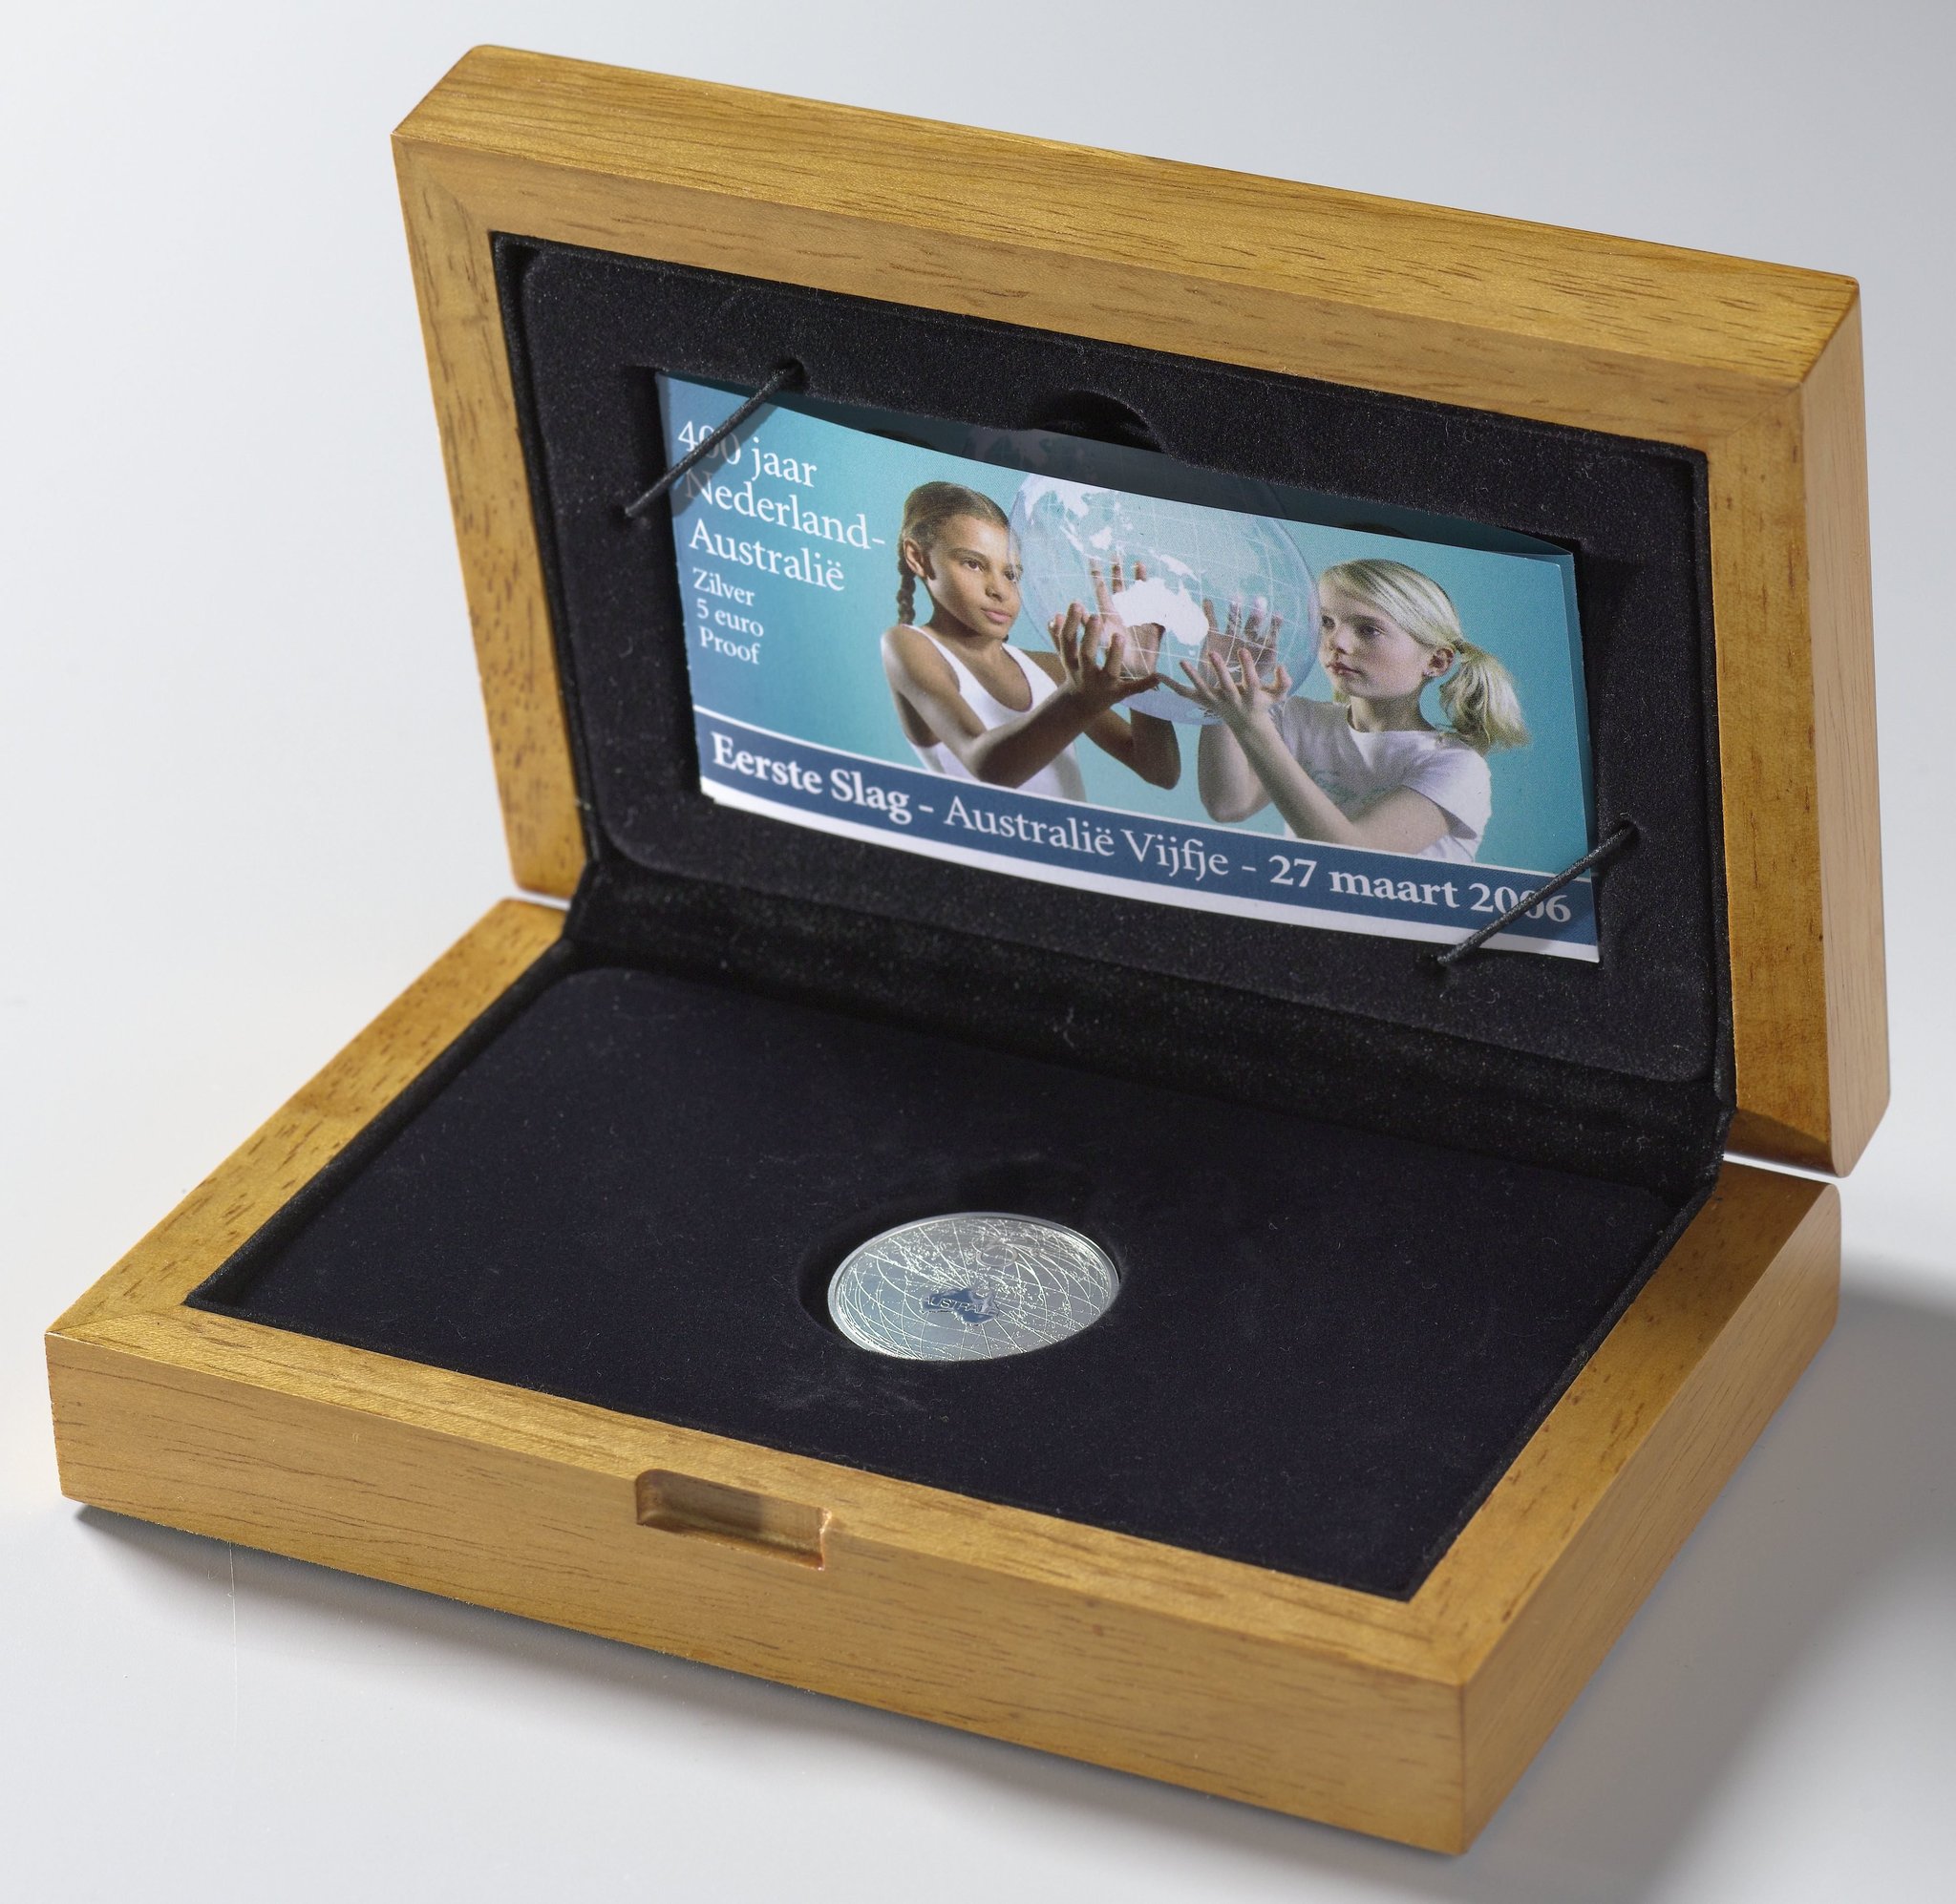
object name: box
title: Houten doosje bij munt Australië Vijfje 2006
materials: metal, paper, velvet, wood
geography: utrecht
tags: netherlands, australia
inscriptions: inscription: ‘Eerste slag Australië vijfje 2006 27 maart 2006’, inscription: ‘Koninklijke Nederlandse Munt’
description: Houten doosje met scharnierend deksel met opschrift. Onderzijde v.z.v. mosgroen fluweel. Binnenzijde v.z.v. blauw fluweel met uitsparing voor munt en in de deksel een uitsparing met elastiek voor inlegvelletje waarop informatie over de munt.